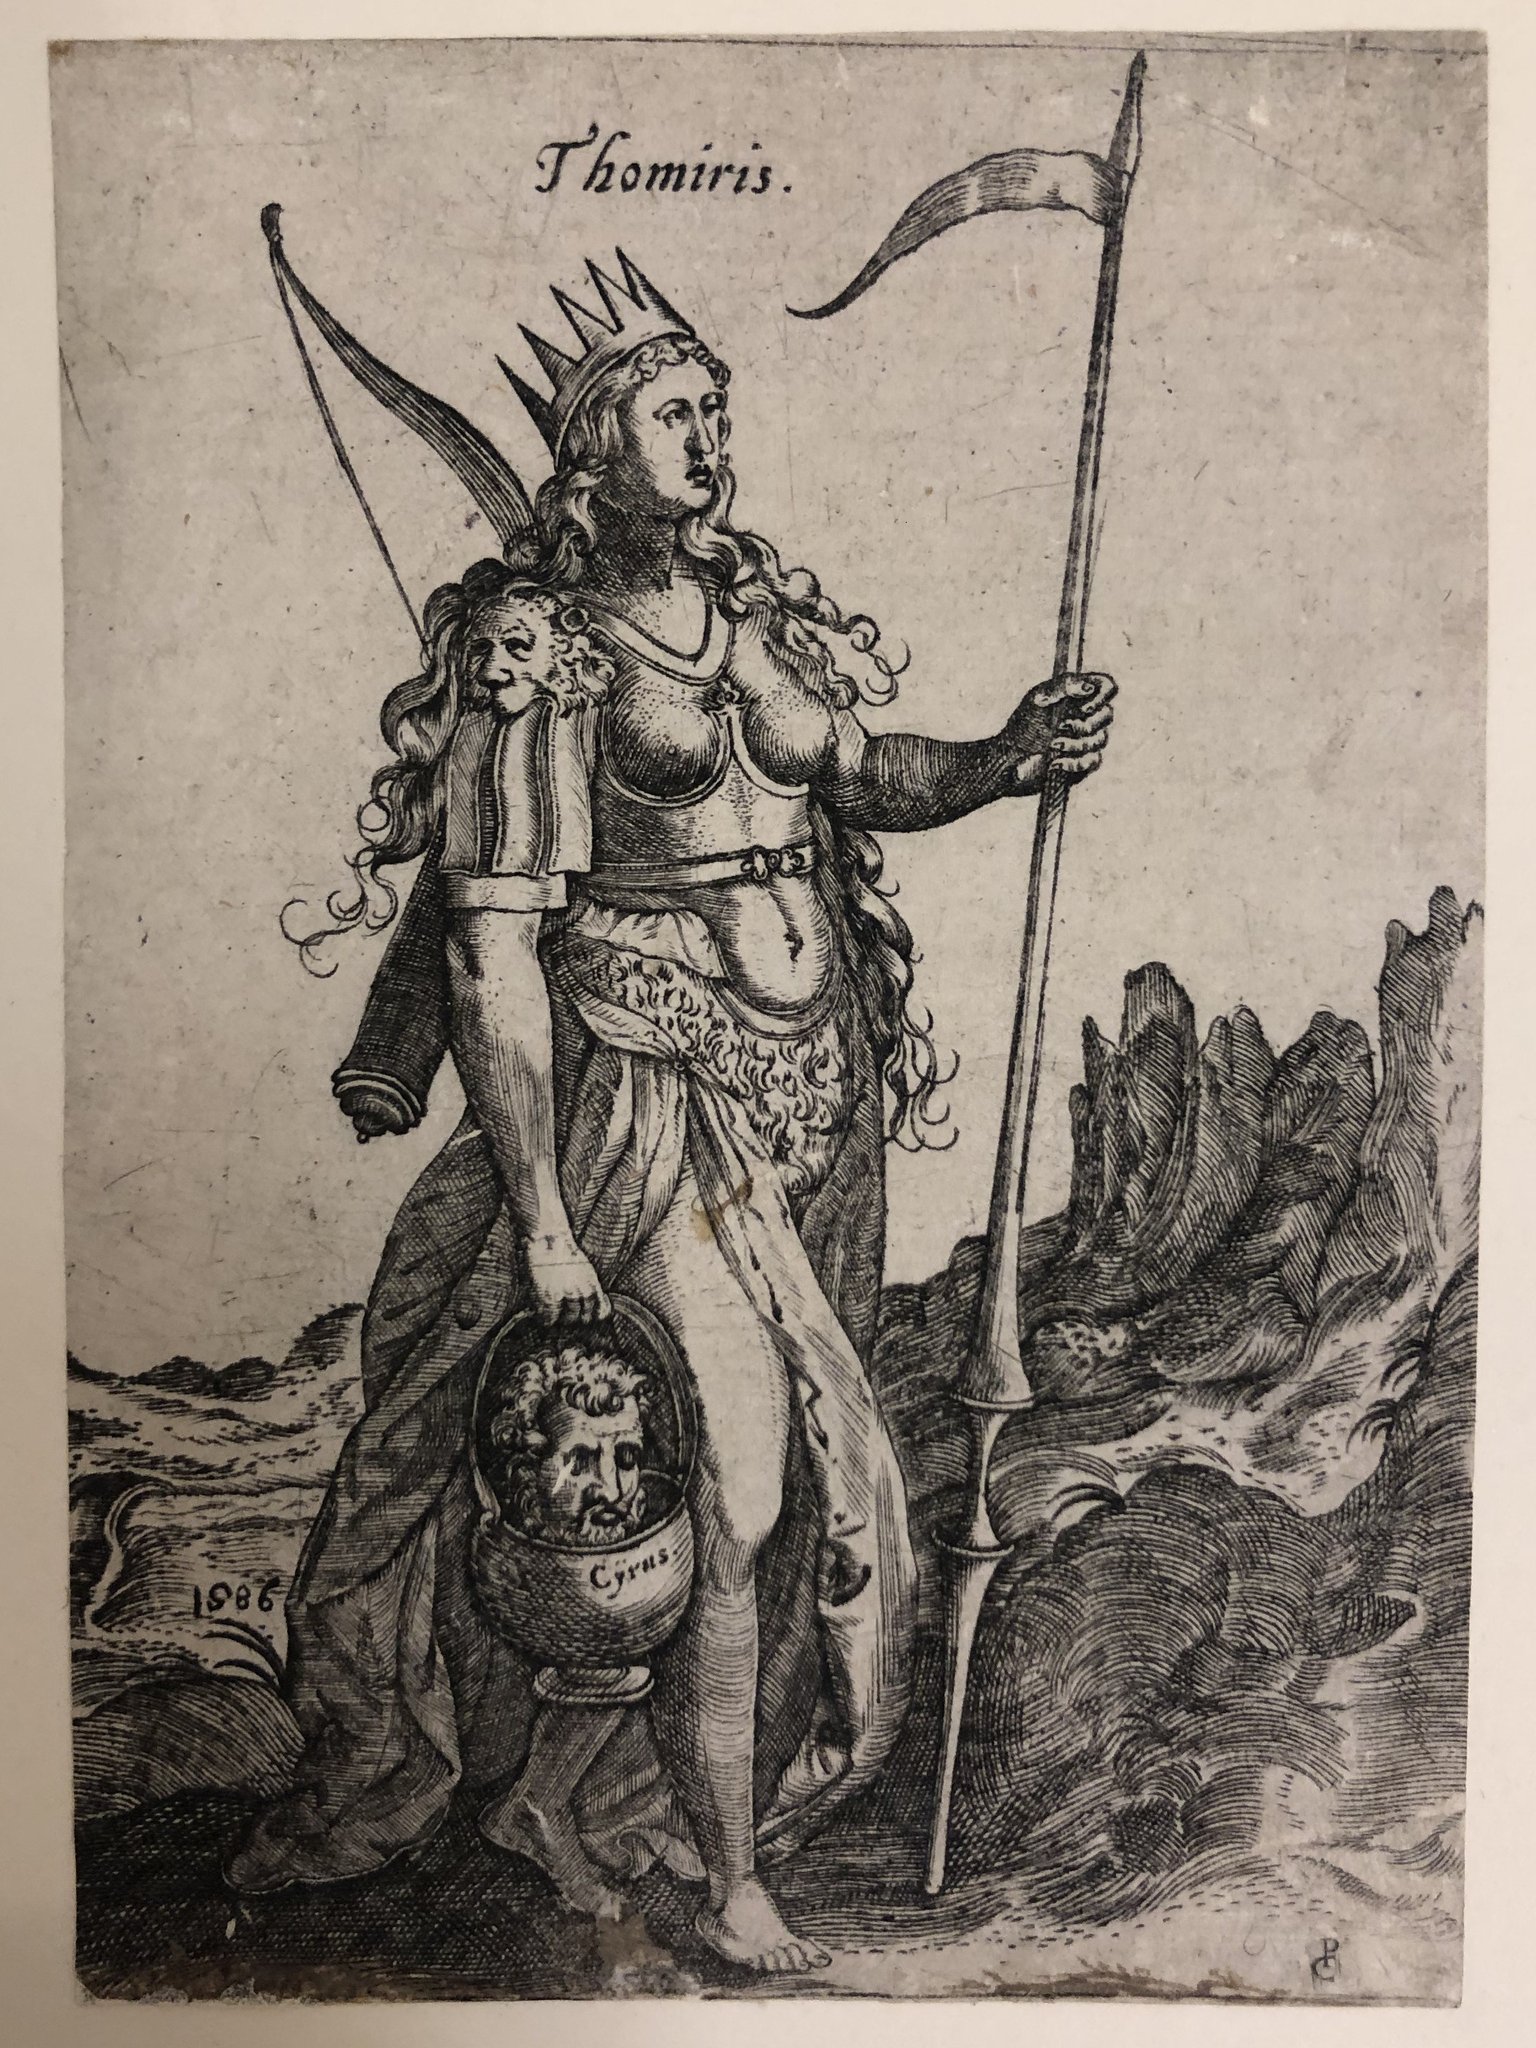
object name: print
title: Tomyris with the Head of King Cyrus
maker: hieronymus wierix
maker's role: artist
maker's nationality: netherlandish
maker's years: 1553-1619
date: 1586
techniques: etching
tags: women,keys